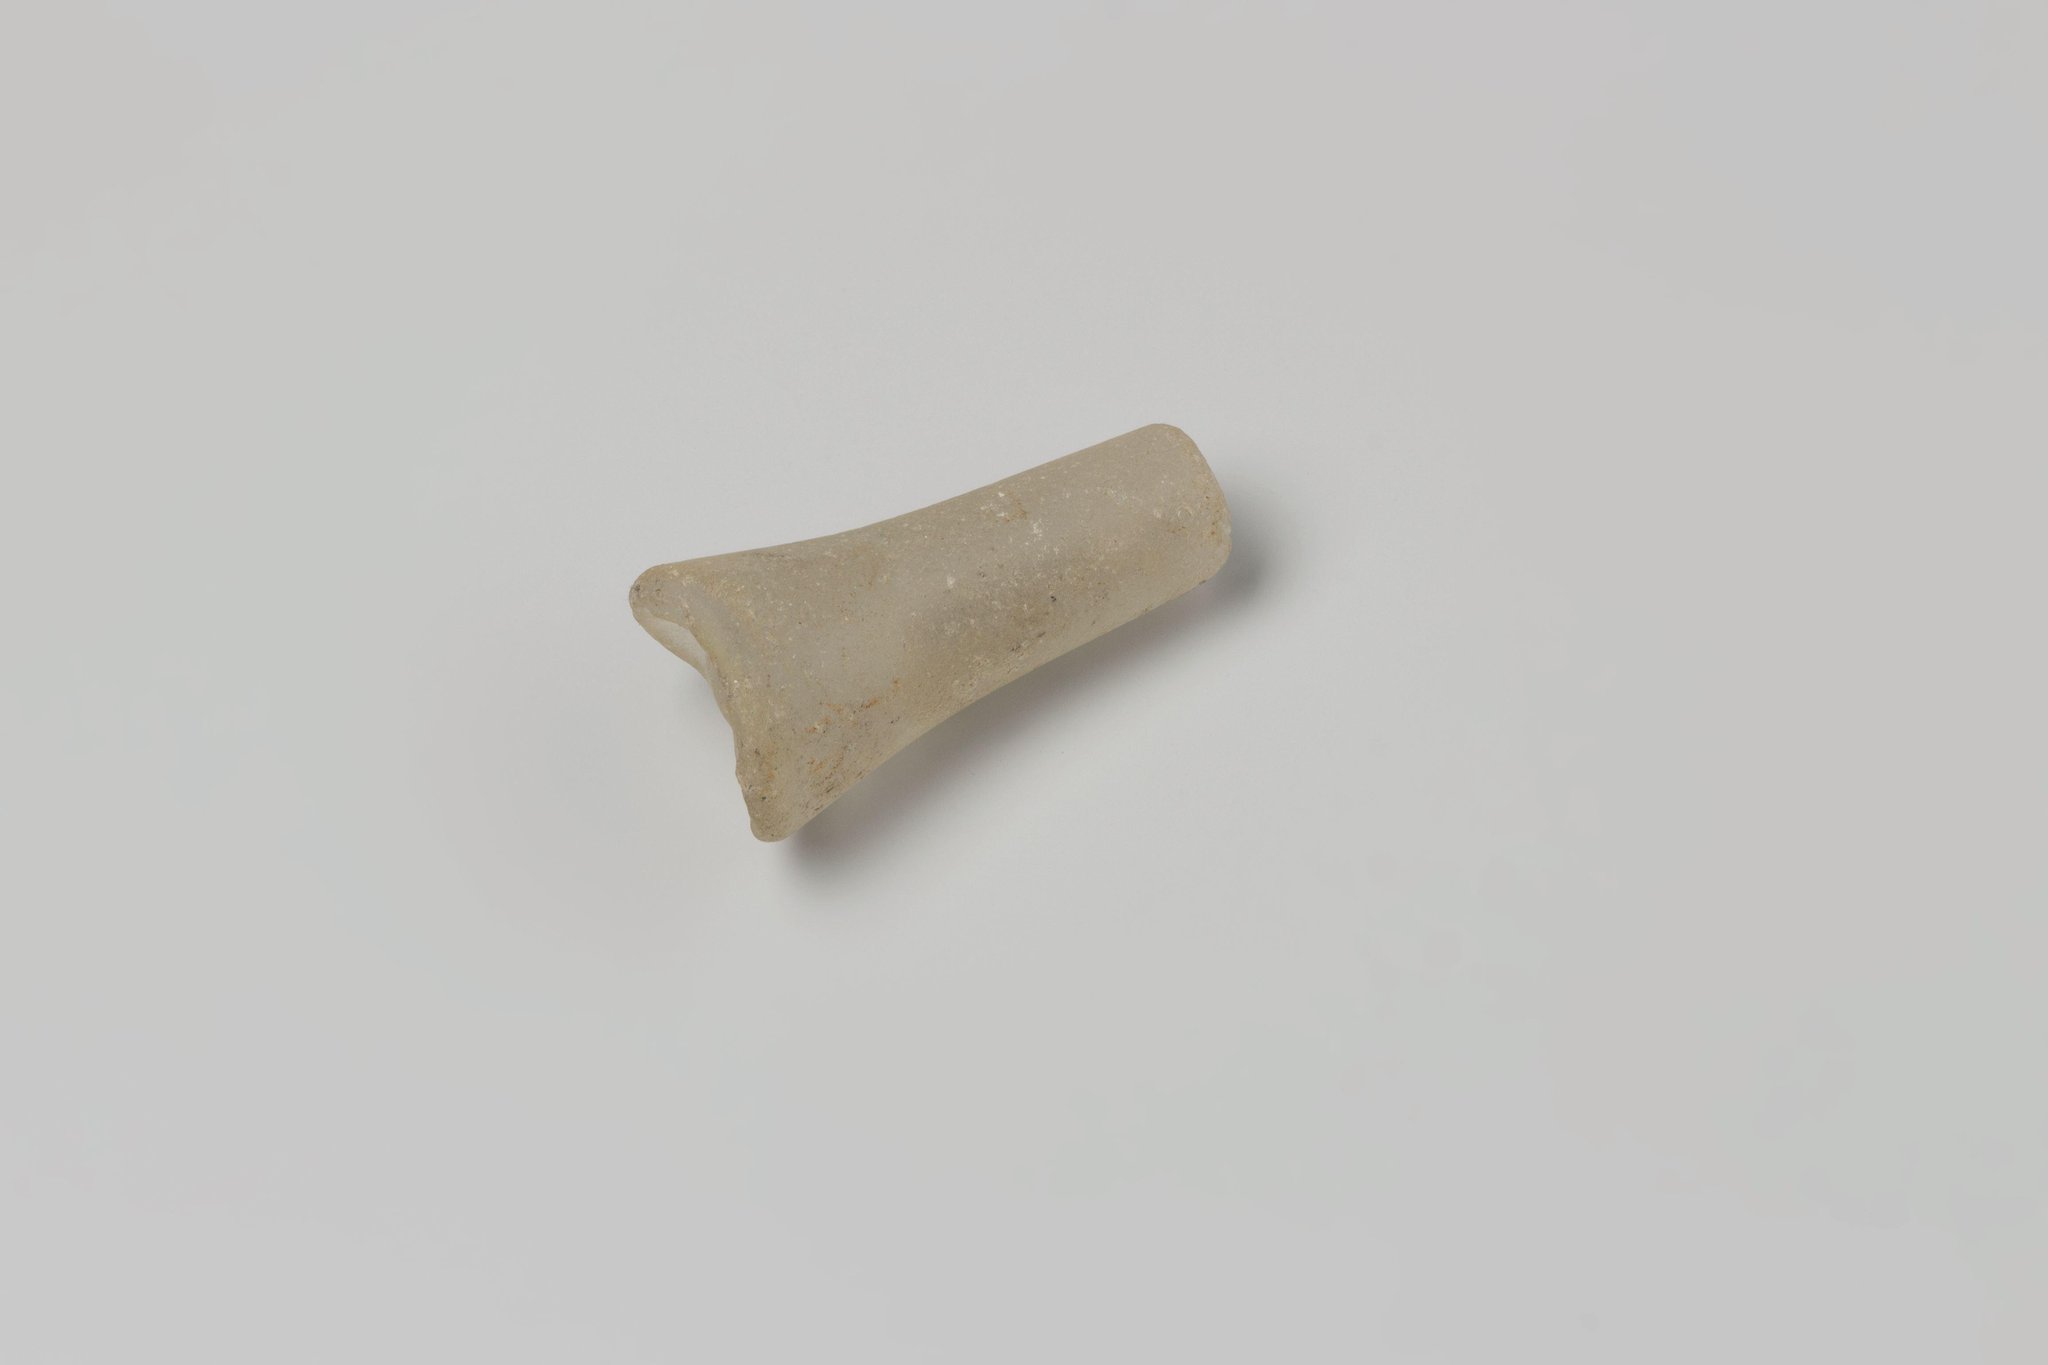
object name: drinking glass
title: Rechte steel van glas uit het wrak van de Oost-Indiëvaarder Hollandia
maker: Anonymous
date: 1700-1743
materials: glass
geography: netherlands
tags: verenigde oostindische compagnie, hollandia (schip), annet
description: Glass, stem glass, stems, plain; fragm, id. NG 1980-27H798.